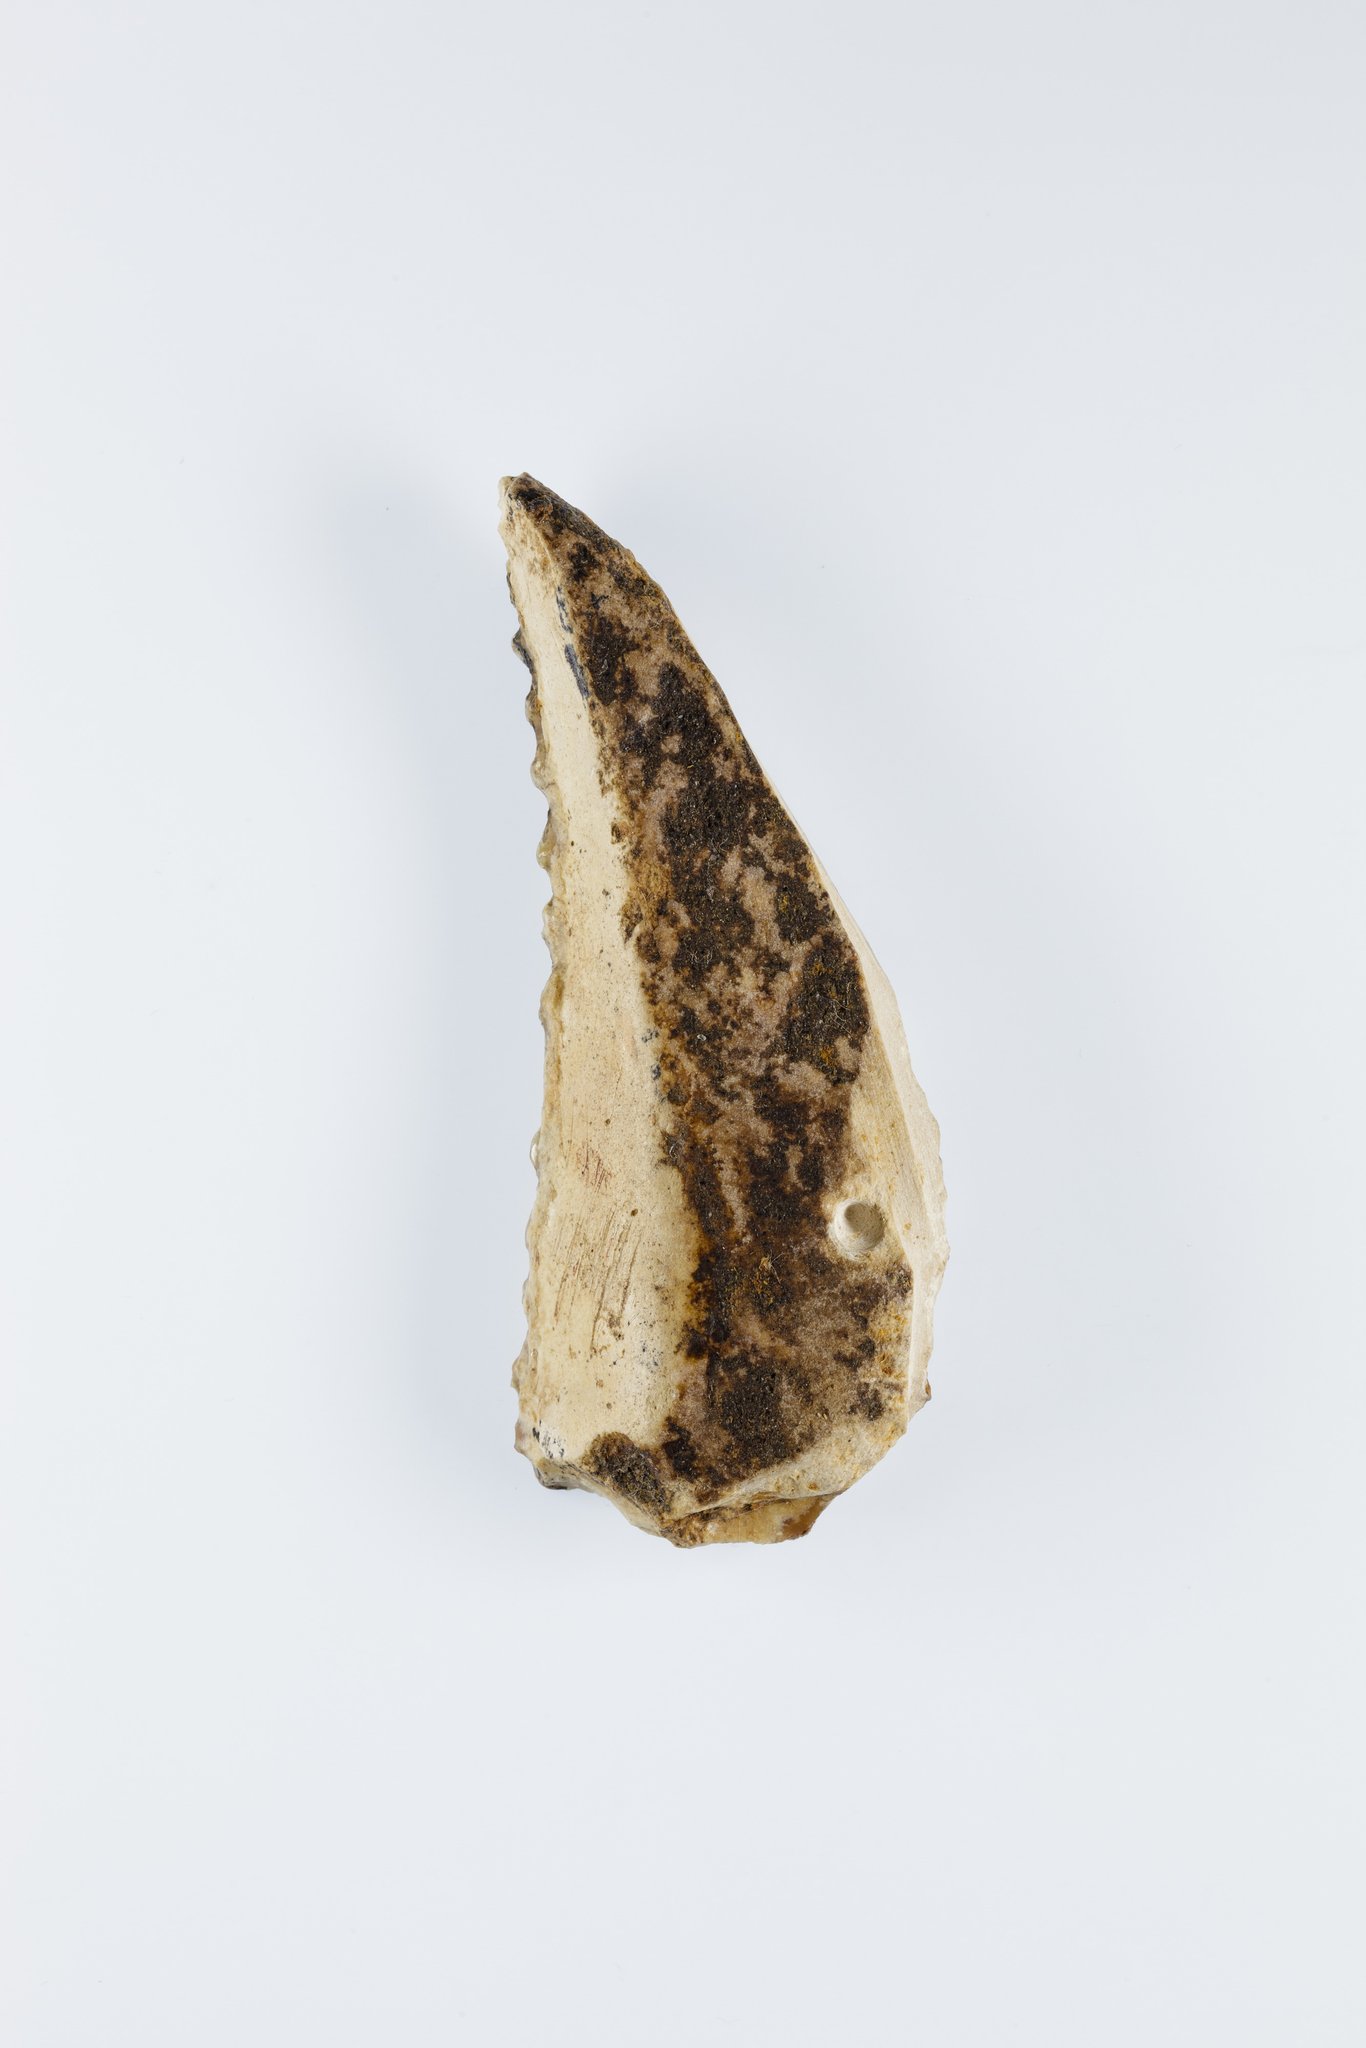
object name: sickle, denticulate, truncated, backed, geometric, tool, element, adhesive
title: Sickle Insert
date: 1186-1070 BCE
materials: stone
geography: egypt